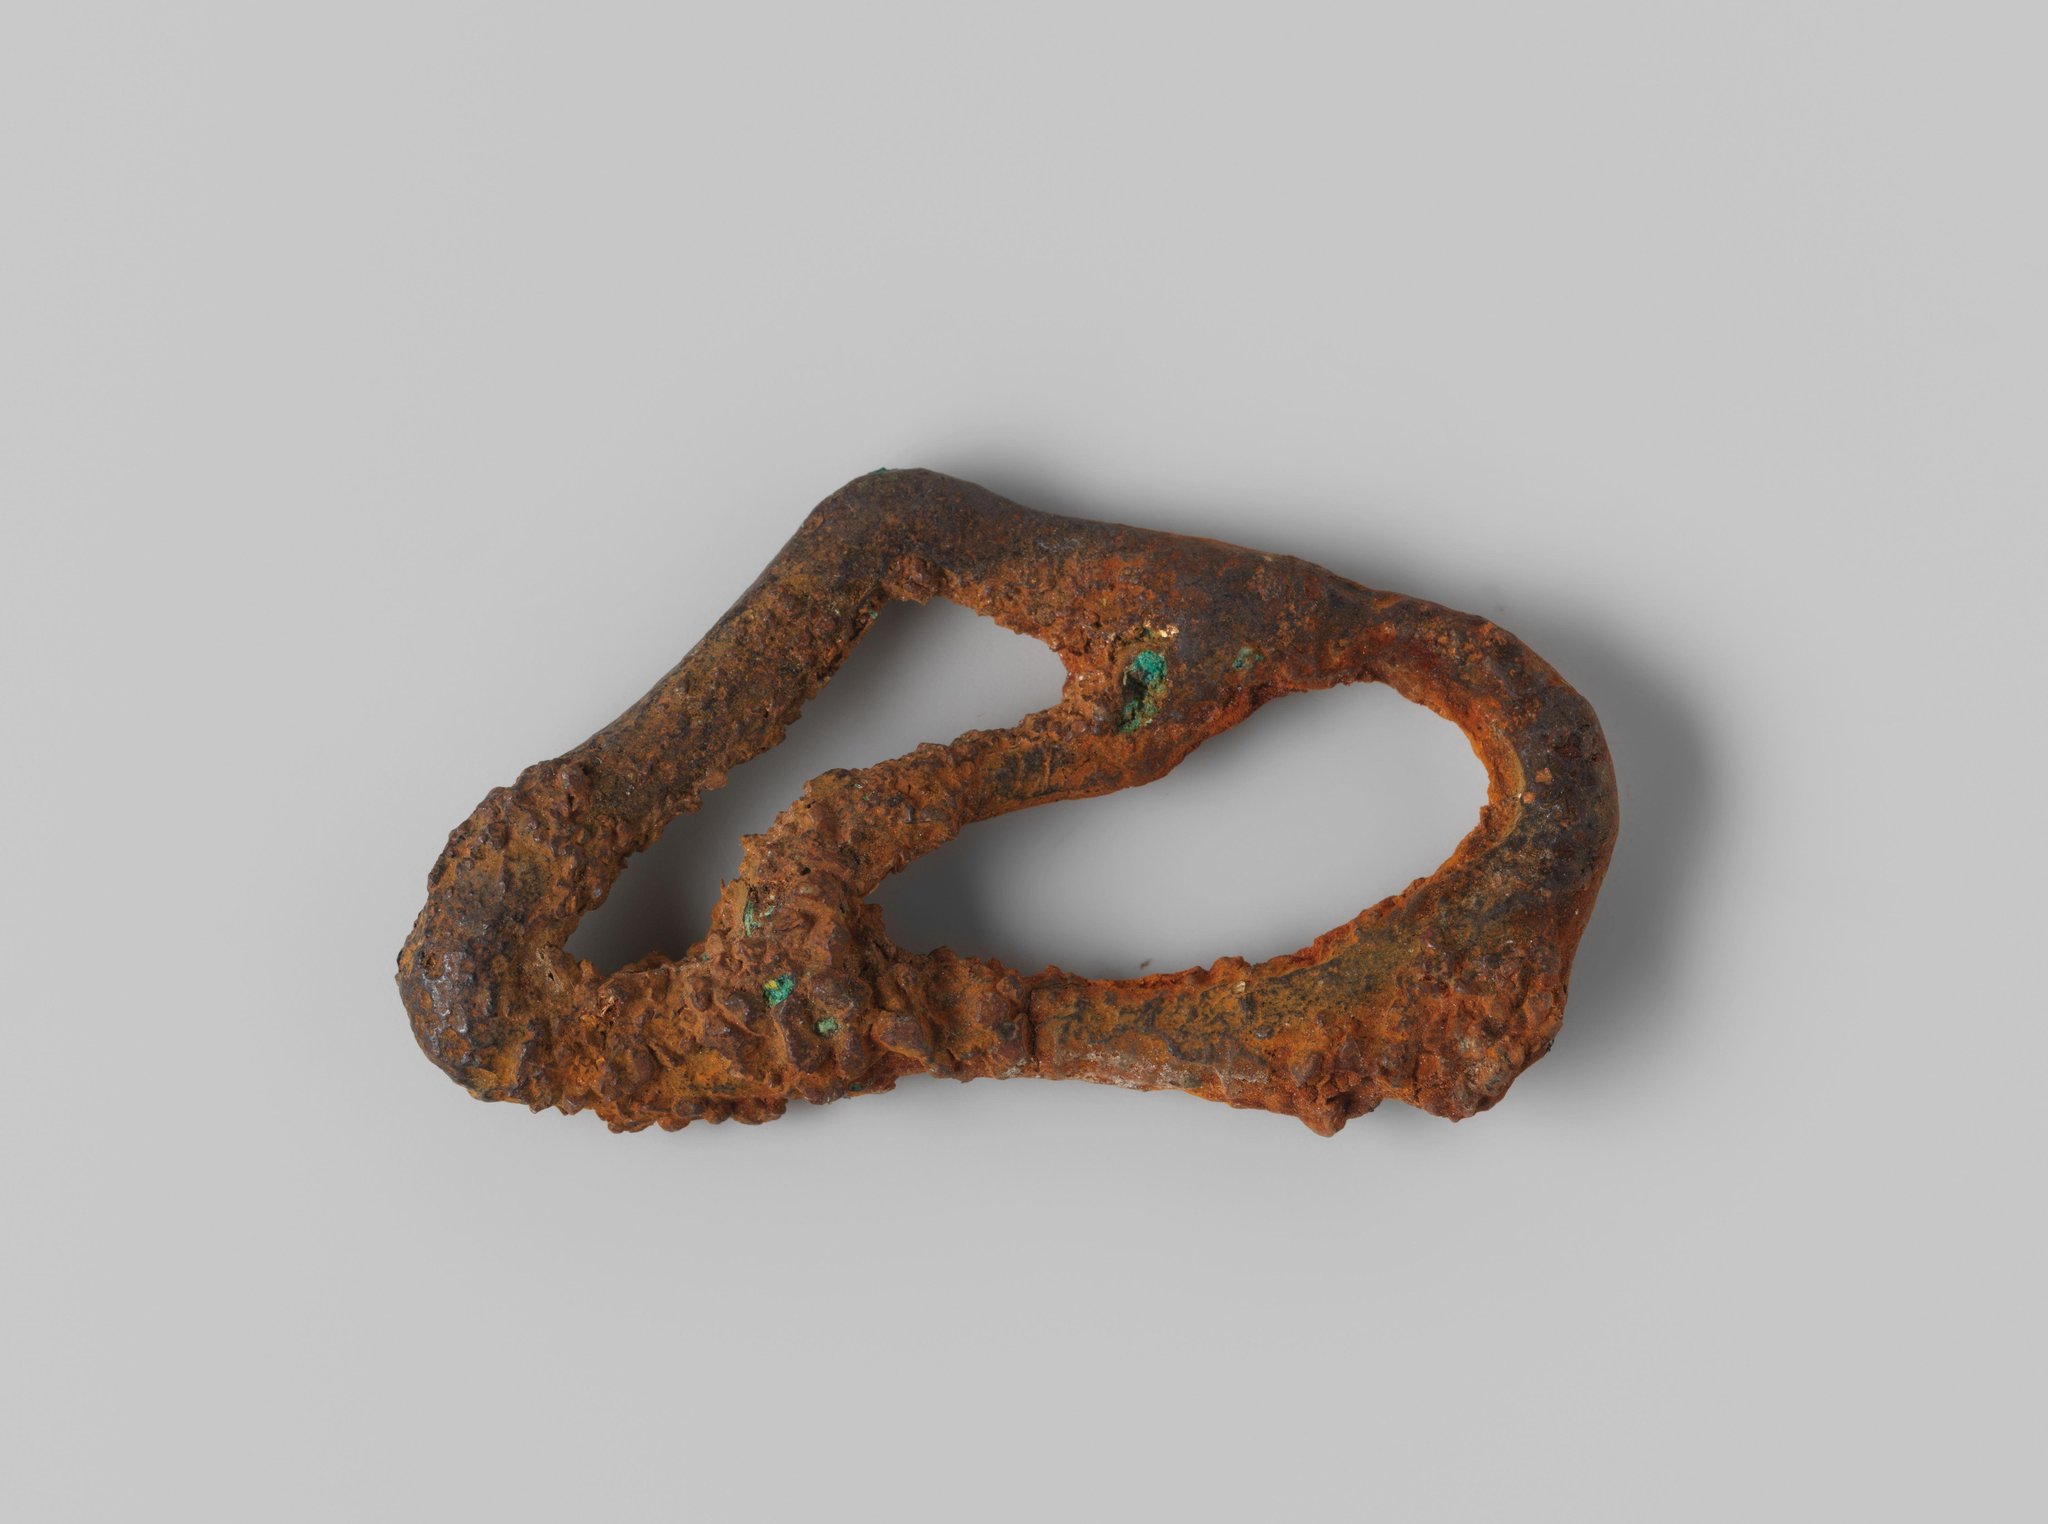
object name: belt buckle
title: Fragment riemgesp uit het wrak van de Oost-Indiëvaarder Hollandia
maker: Anonymous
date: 1700-1743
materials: copper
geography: netherlands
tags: verenigde oostindische compagnie, hollandia (schip), annet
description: D-shaped with pointed side, ring, squashed, id. NG 1980-27H384, belt buckle.